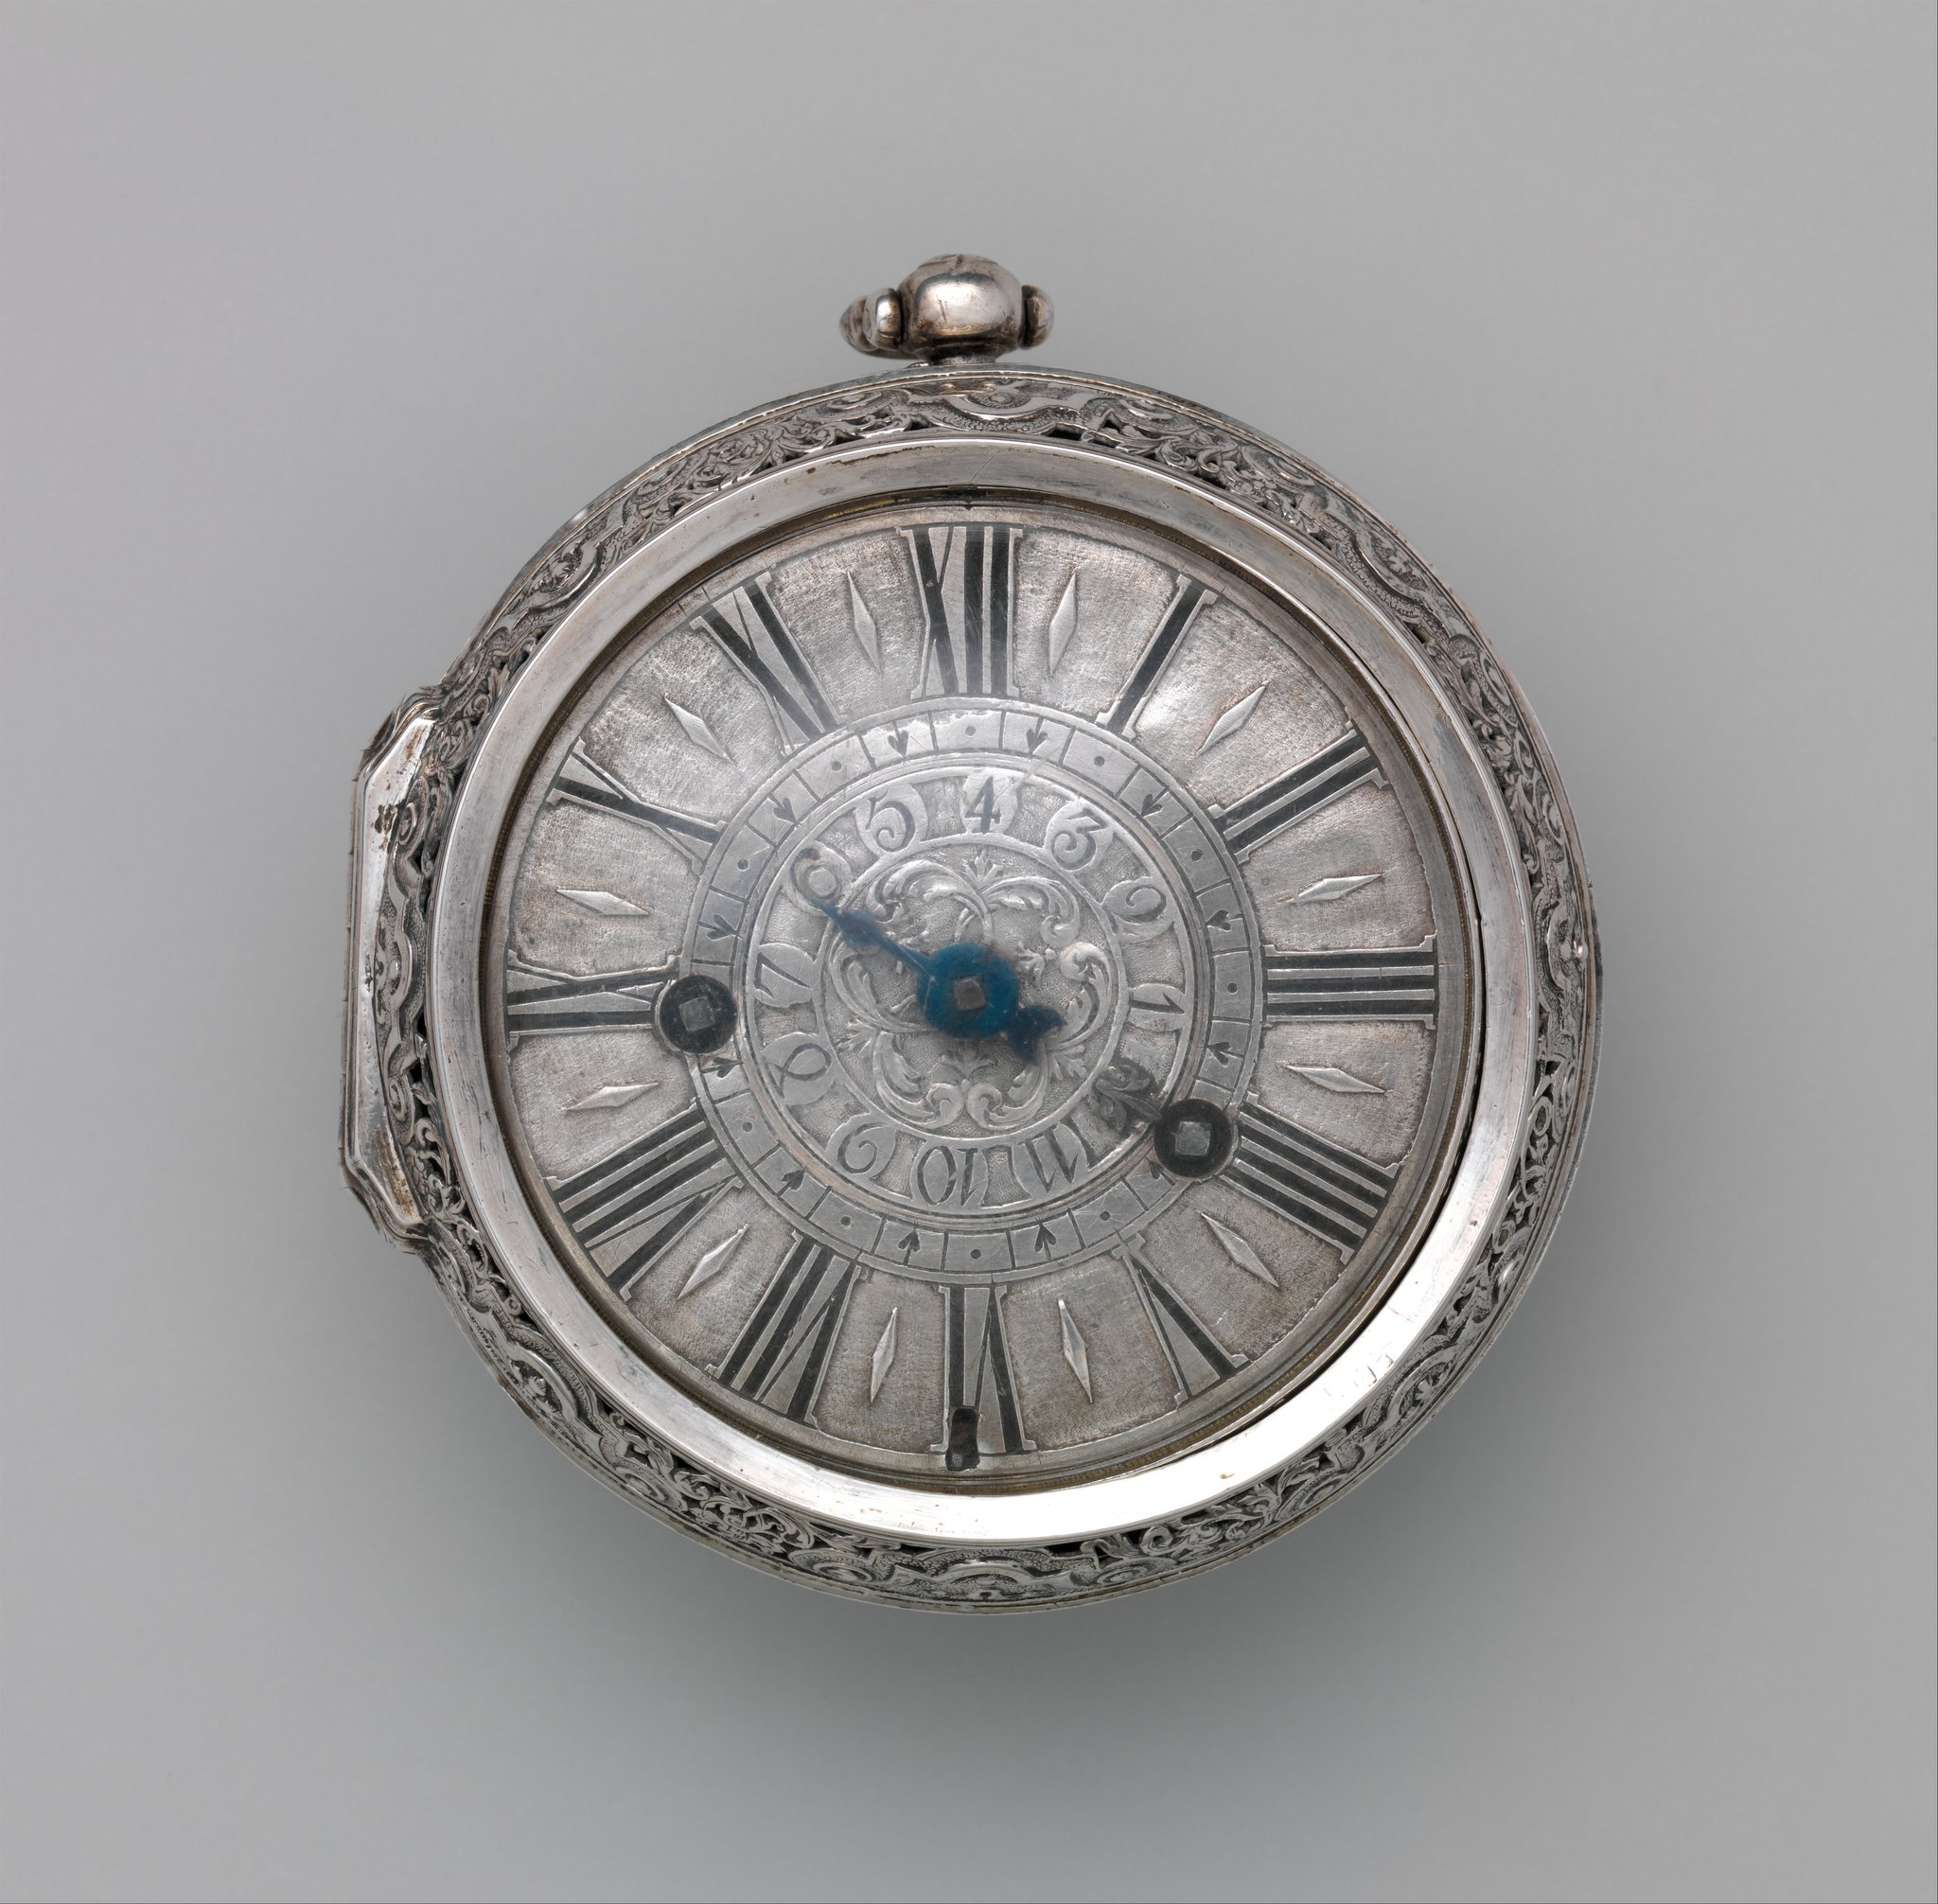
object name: pair case watch with alarm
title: Pair-case watch with alarm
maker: adam roumeau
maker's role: maker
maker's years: 1598-1698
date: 1695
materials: brass, silver, steel